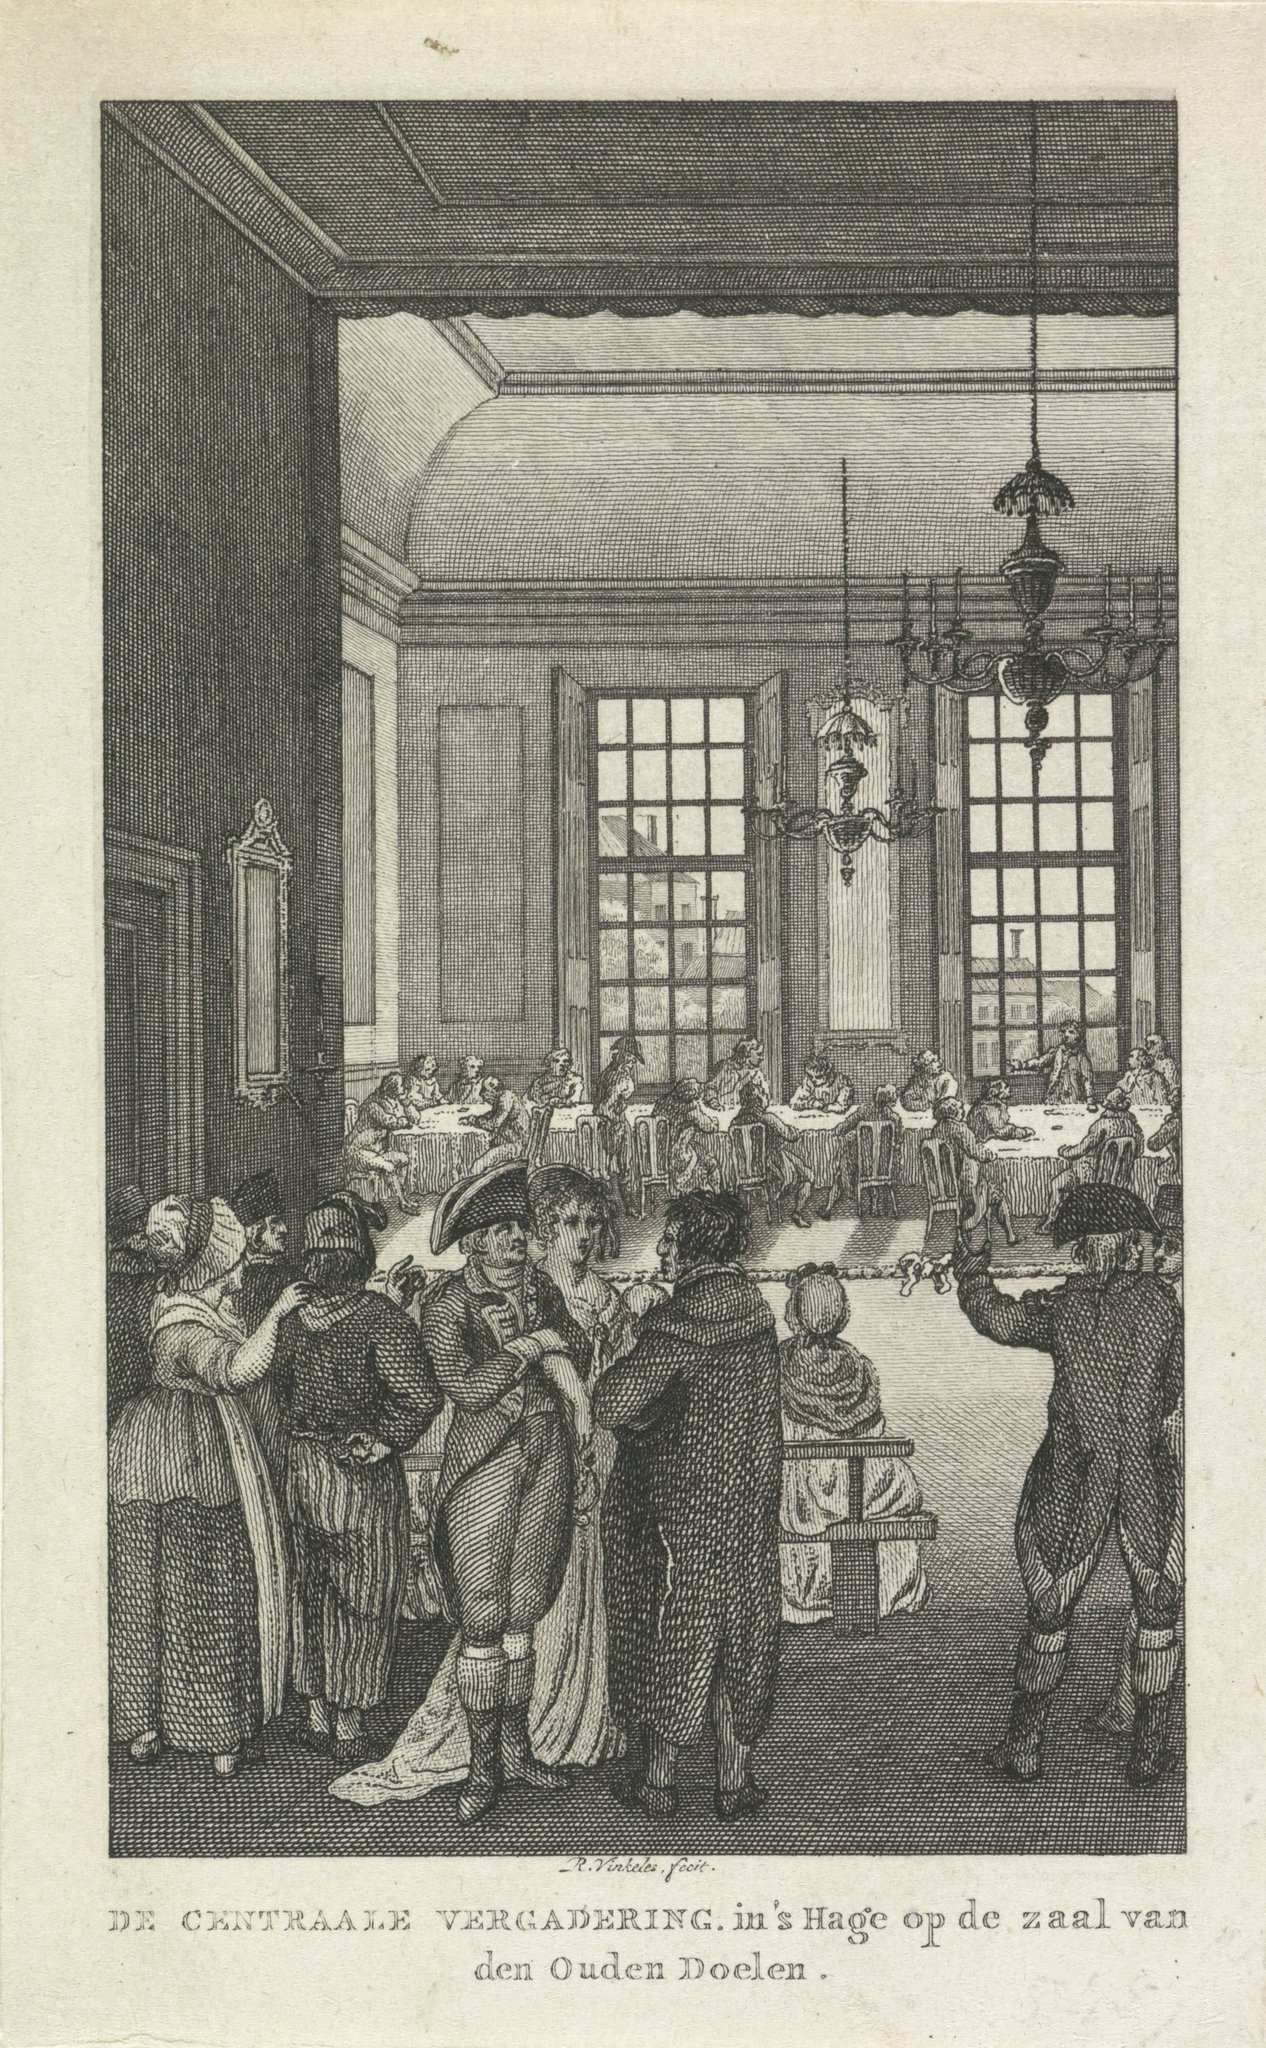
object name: print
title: De Centraale Vergadering. in 's Hage op de zaal van den Ouden Doelen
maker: reinier vinkeles (i)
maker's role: draughtsman, print maker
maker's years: 1741-1816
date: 1803-1805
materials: paper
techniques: engraving, etching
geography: netherlands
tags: national government, politics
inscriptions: collector's mark: Lugt 2228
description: Gebruikt als illustratie in: P.A. Loosjes. Vaderlandsche historie, vervattende de geschiedenissen, der Vereenigde Nederlanden (...). Ten onmiddelyken vervolge van Wagenaar's Vaderlandsche historie. Amsterdam: Johannes Allart, dl. 34 (1805).